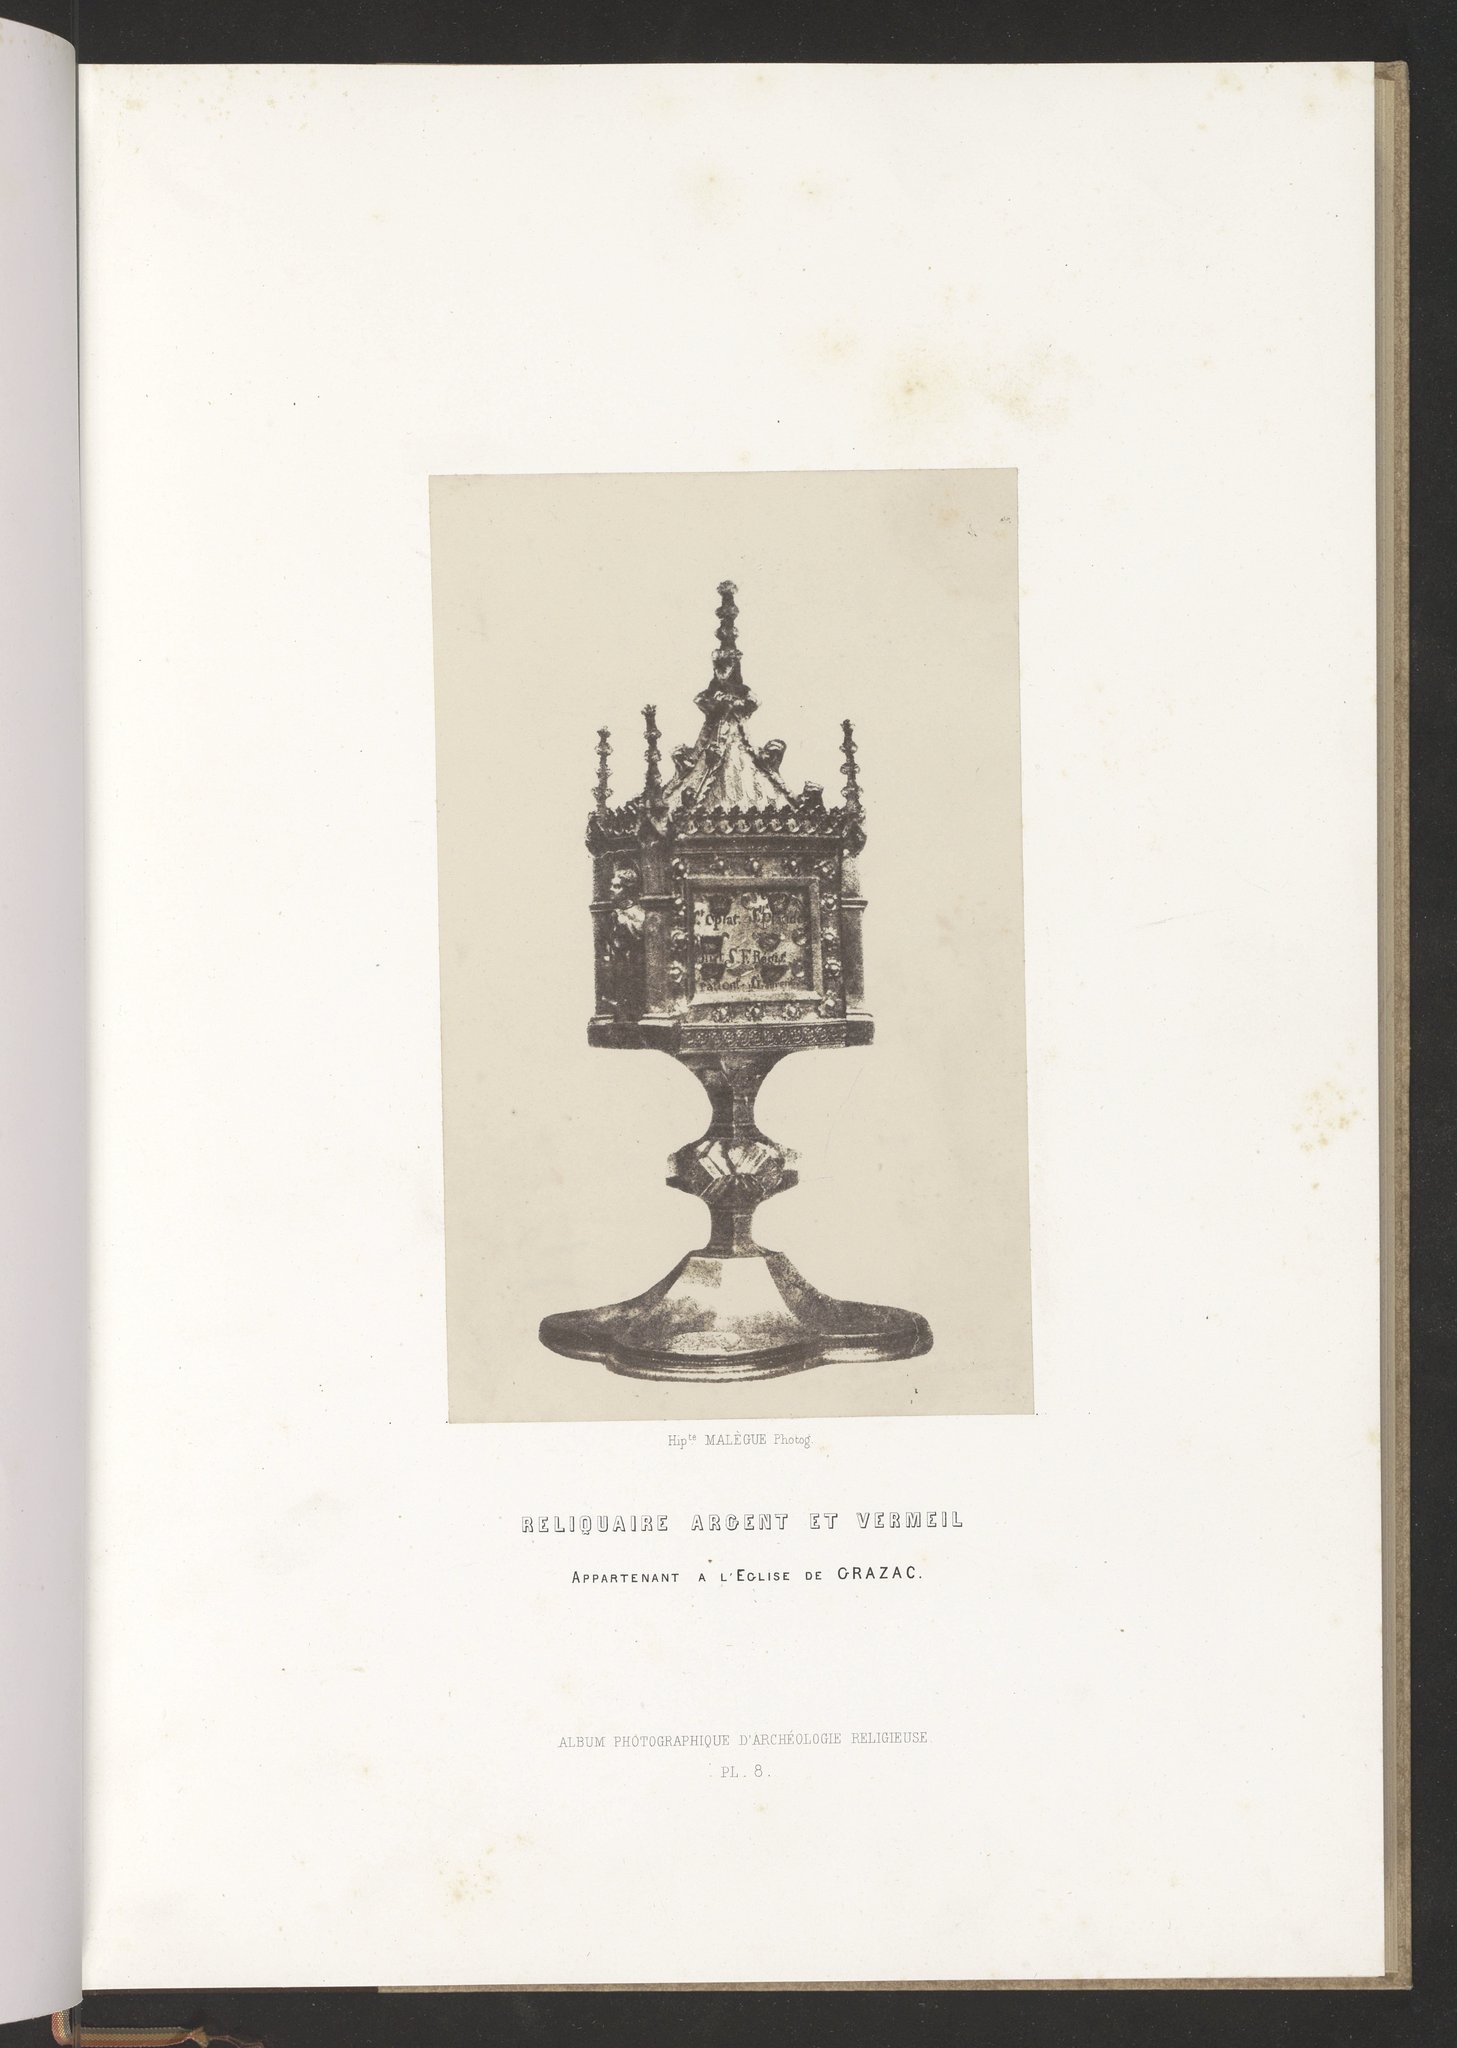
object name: page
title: Zilveren reliekhouder afkomstig uit een kerk te Gazac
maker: hippolyte malègue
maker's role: archeoloog, fotograaf, schrijver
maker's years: 1825-1901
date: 1850-1857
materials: photographic support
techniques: salted paper print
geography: france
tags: relics (and reliquaries)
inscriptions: number: ‘PL. 8.’, inscription: ‘appartenant a l'eglise de Grazac’